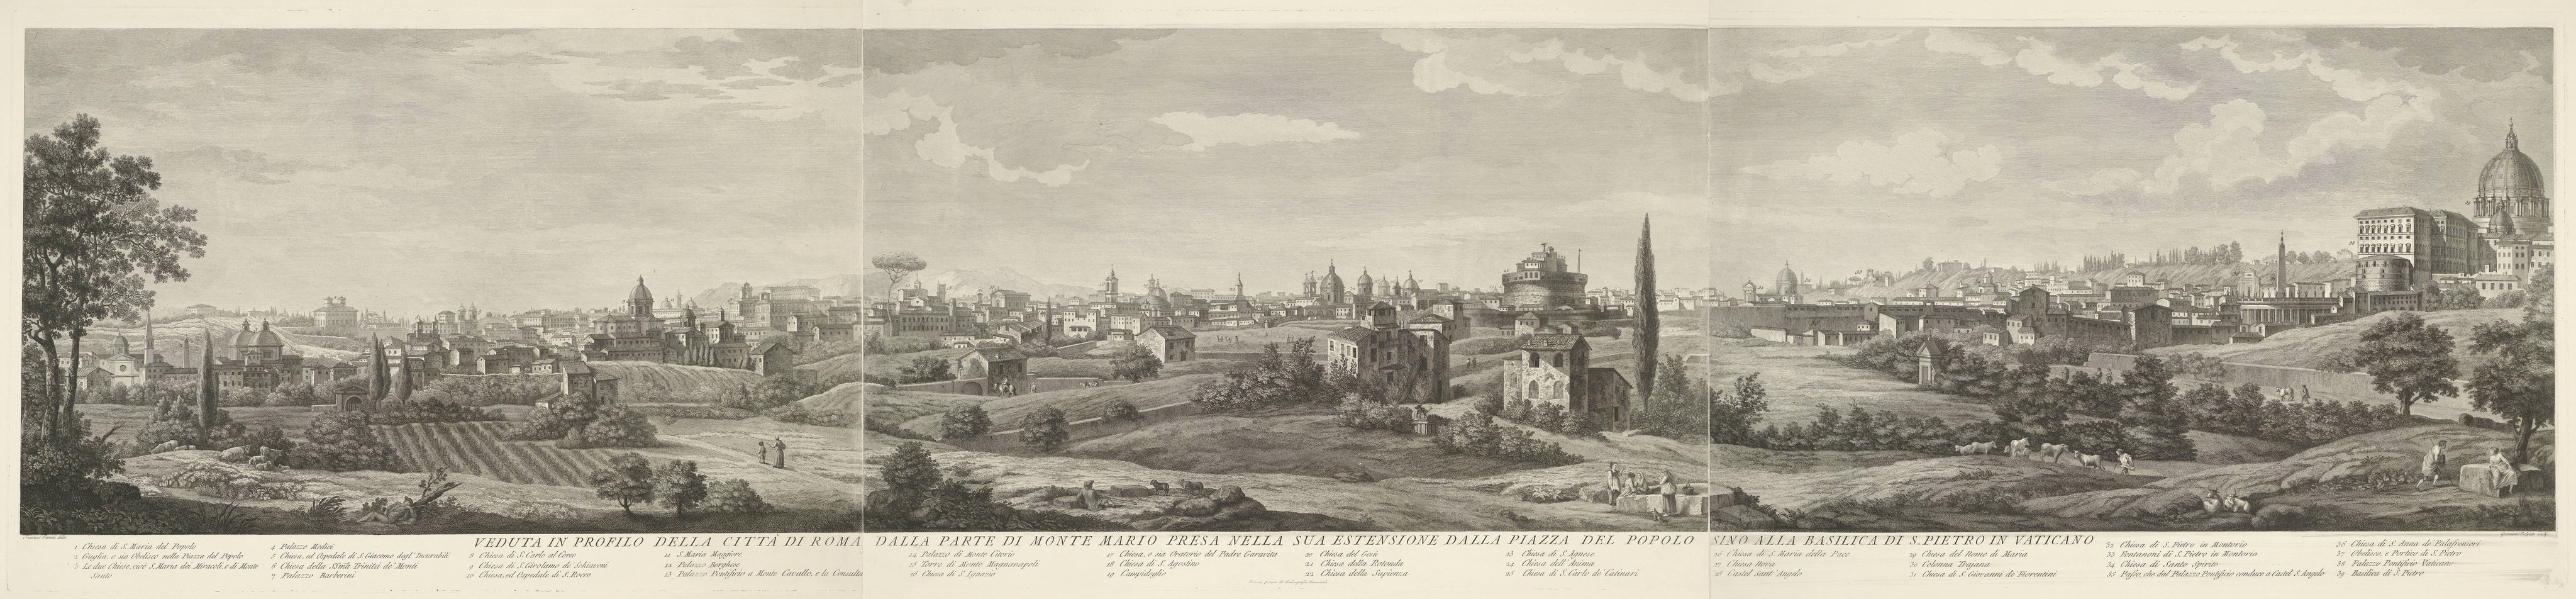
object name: print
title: Panorama van de stad Rome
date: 1743-1803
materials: paper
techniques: etching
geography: italy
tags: panorama, cyclorama, city-view in general; 'veduta', rome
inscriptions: collector's mark: Lugt 2228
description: Panorama van de stad Rome, gezien vanaf de Monte Mario. Verklarende lijst met nummers in ondermarge.